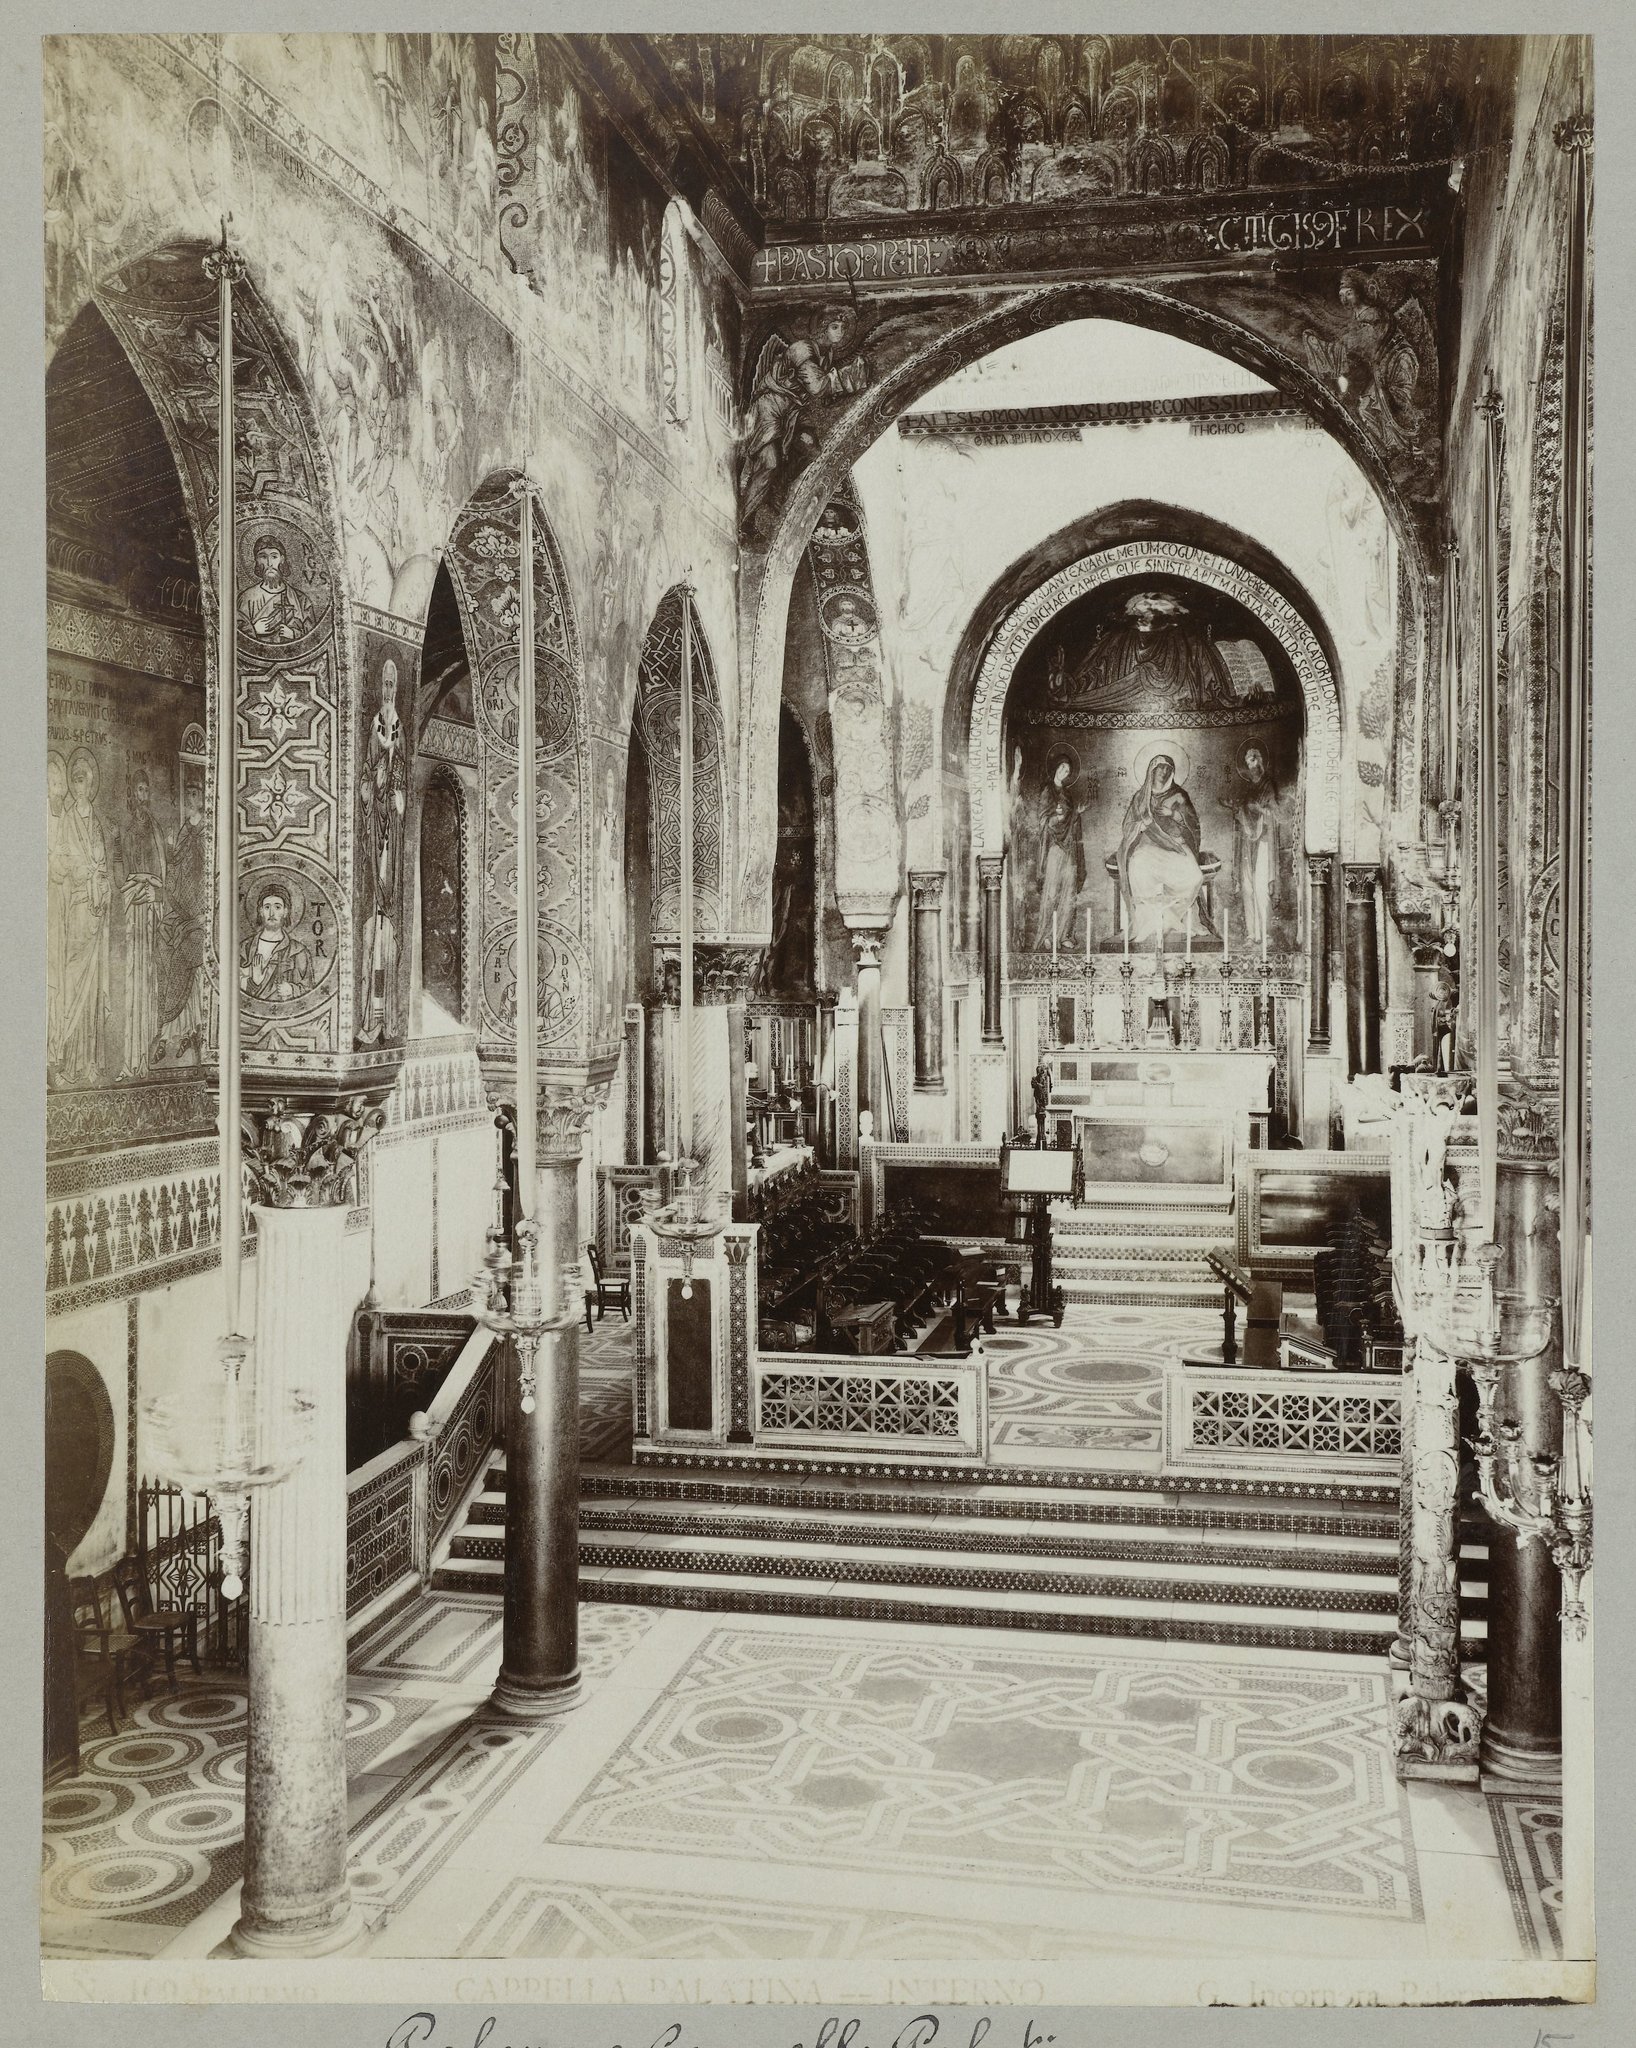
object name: photograph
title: Palermo, Cappella Palatina.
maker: giuseppe incorpora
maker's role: fotograaf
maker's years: 1834-1914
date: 1893-1903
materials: cardboard, photographic support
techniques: albumen print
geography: netherlands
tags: palermo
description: Het interieur van de palatina kapel in het palazzo Reale.